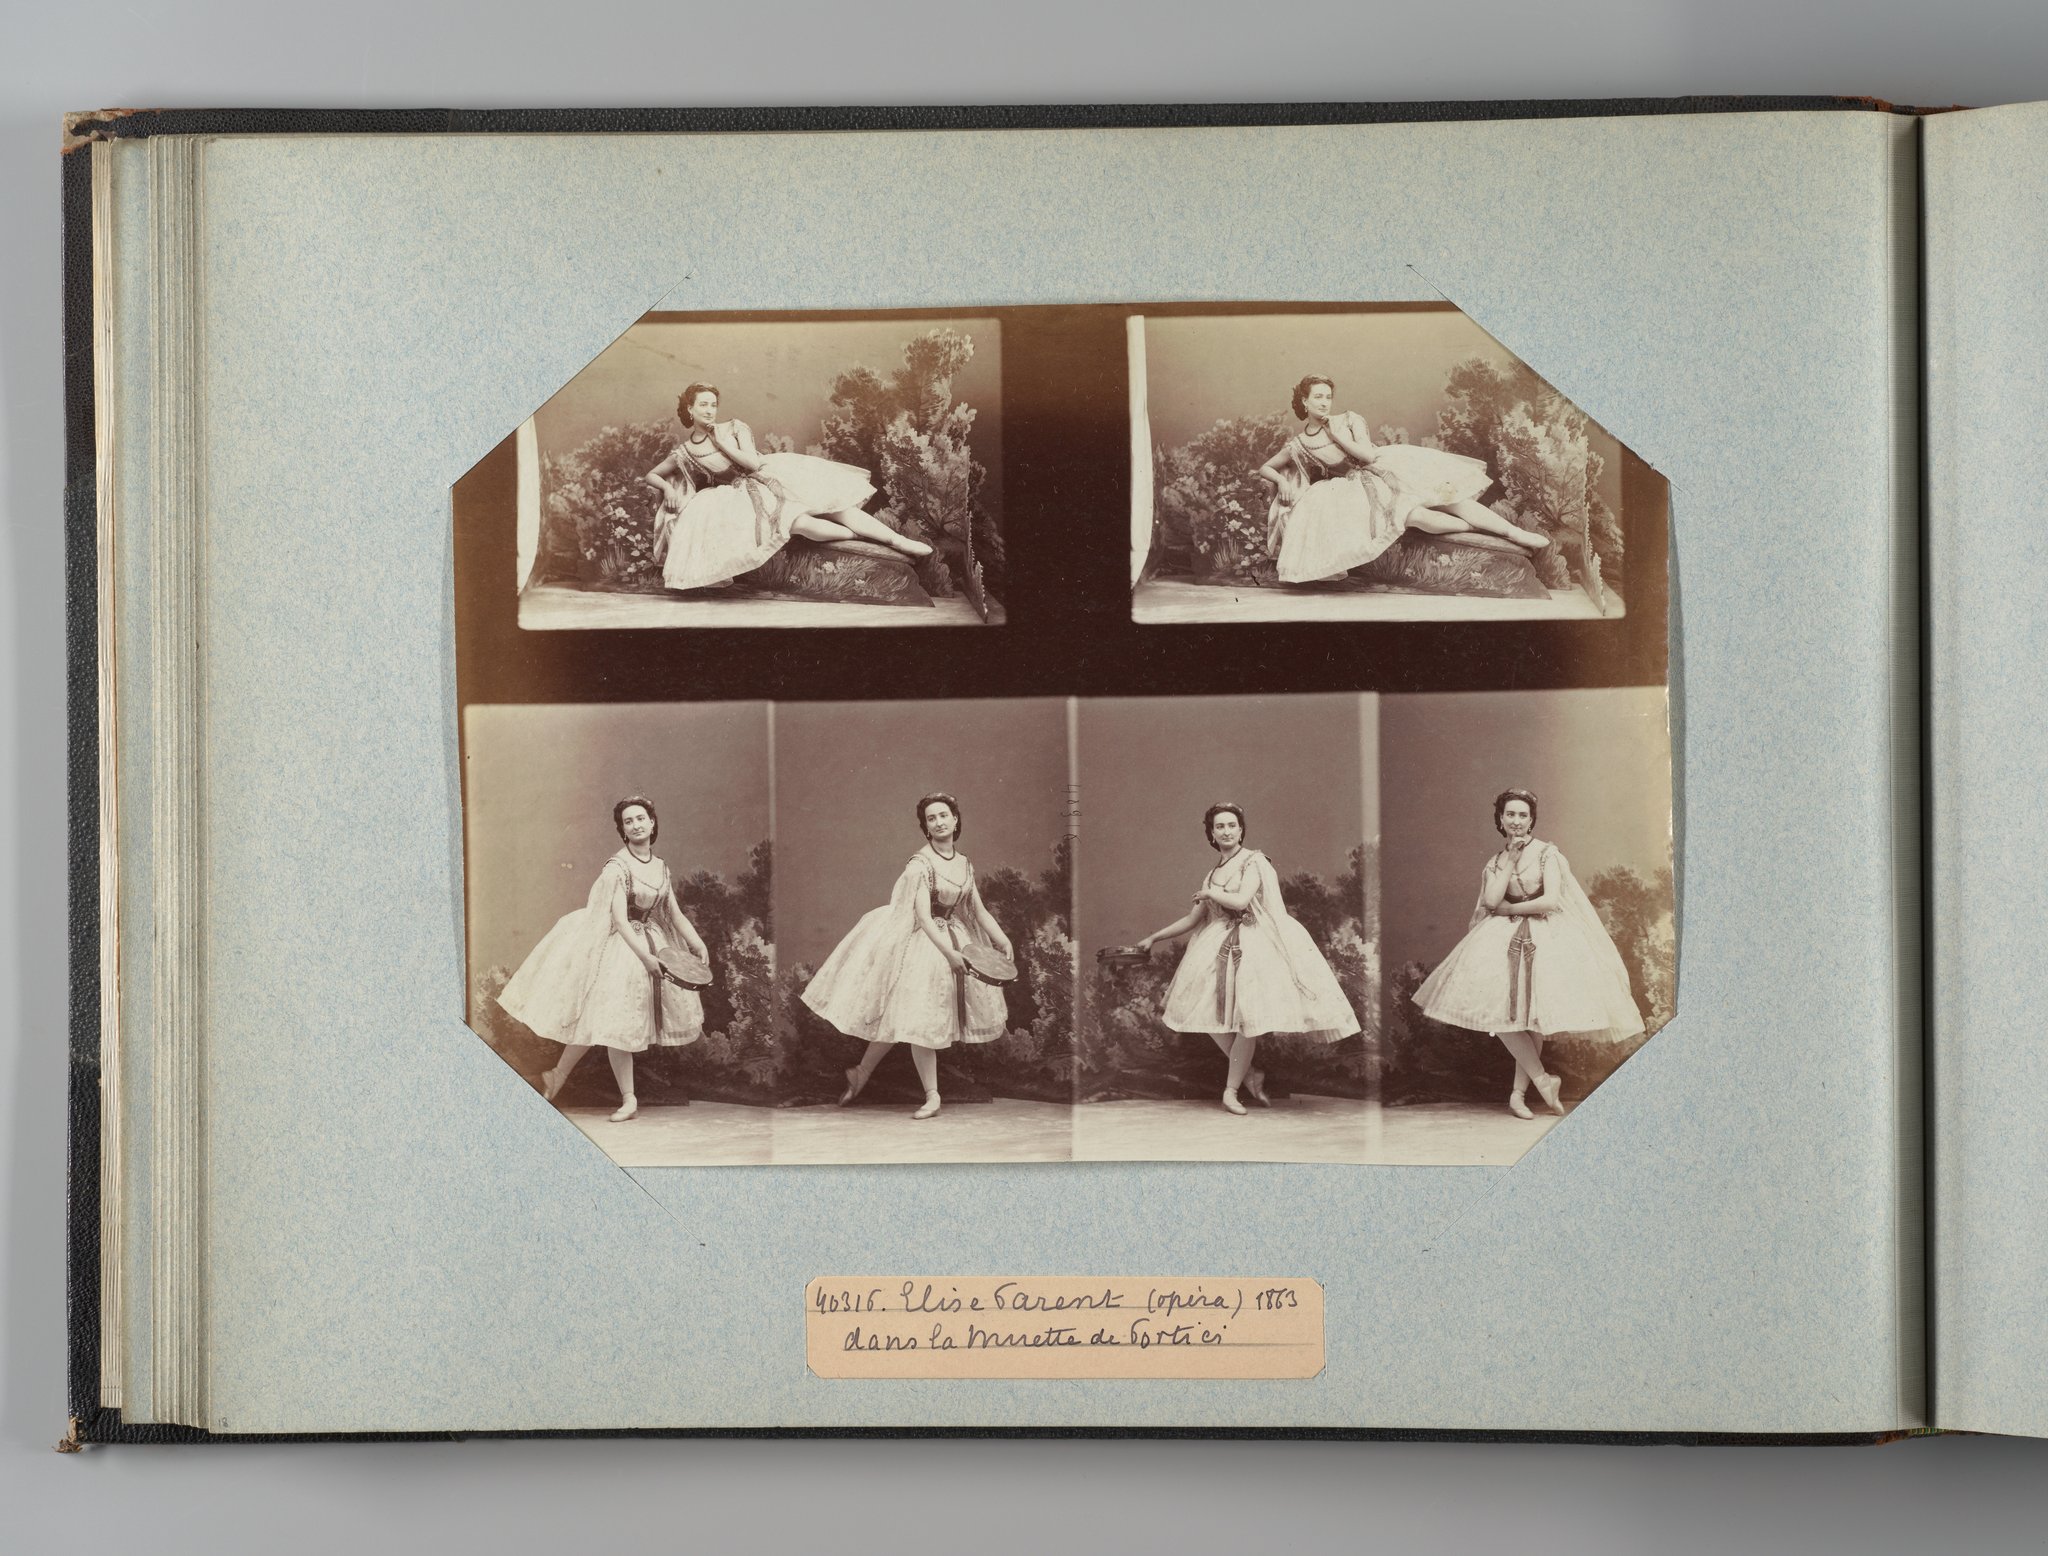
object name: photograph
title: Elise Parent (opéra) 1863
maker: andré-adolphe-eugène disdéri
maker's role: artist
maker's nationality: french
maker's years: 1819-1889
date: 1863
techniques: albumen silver print, glass negative